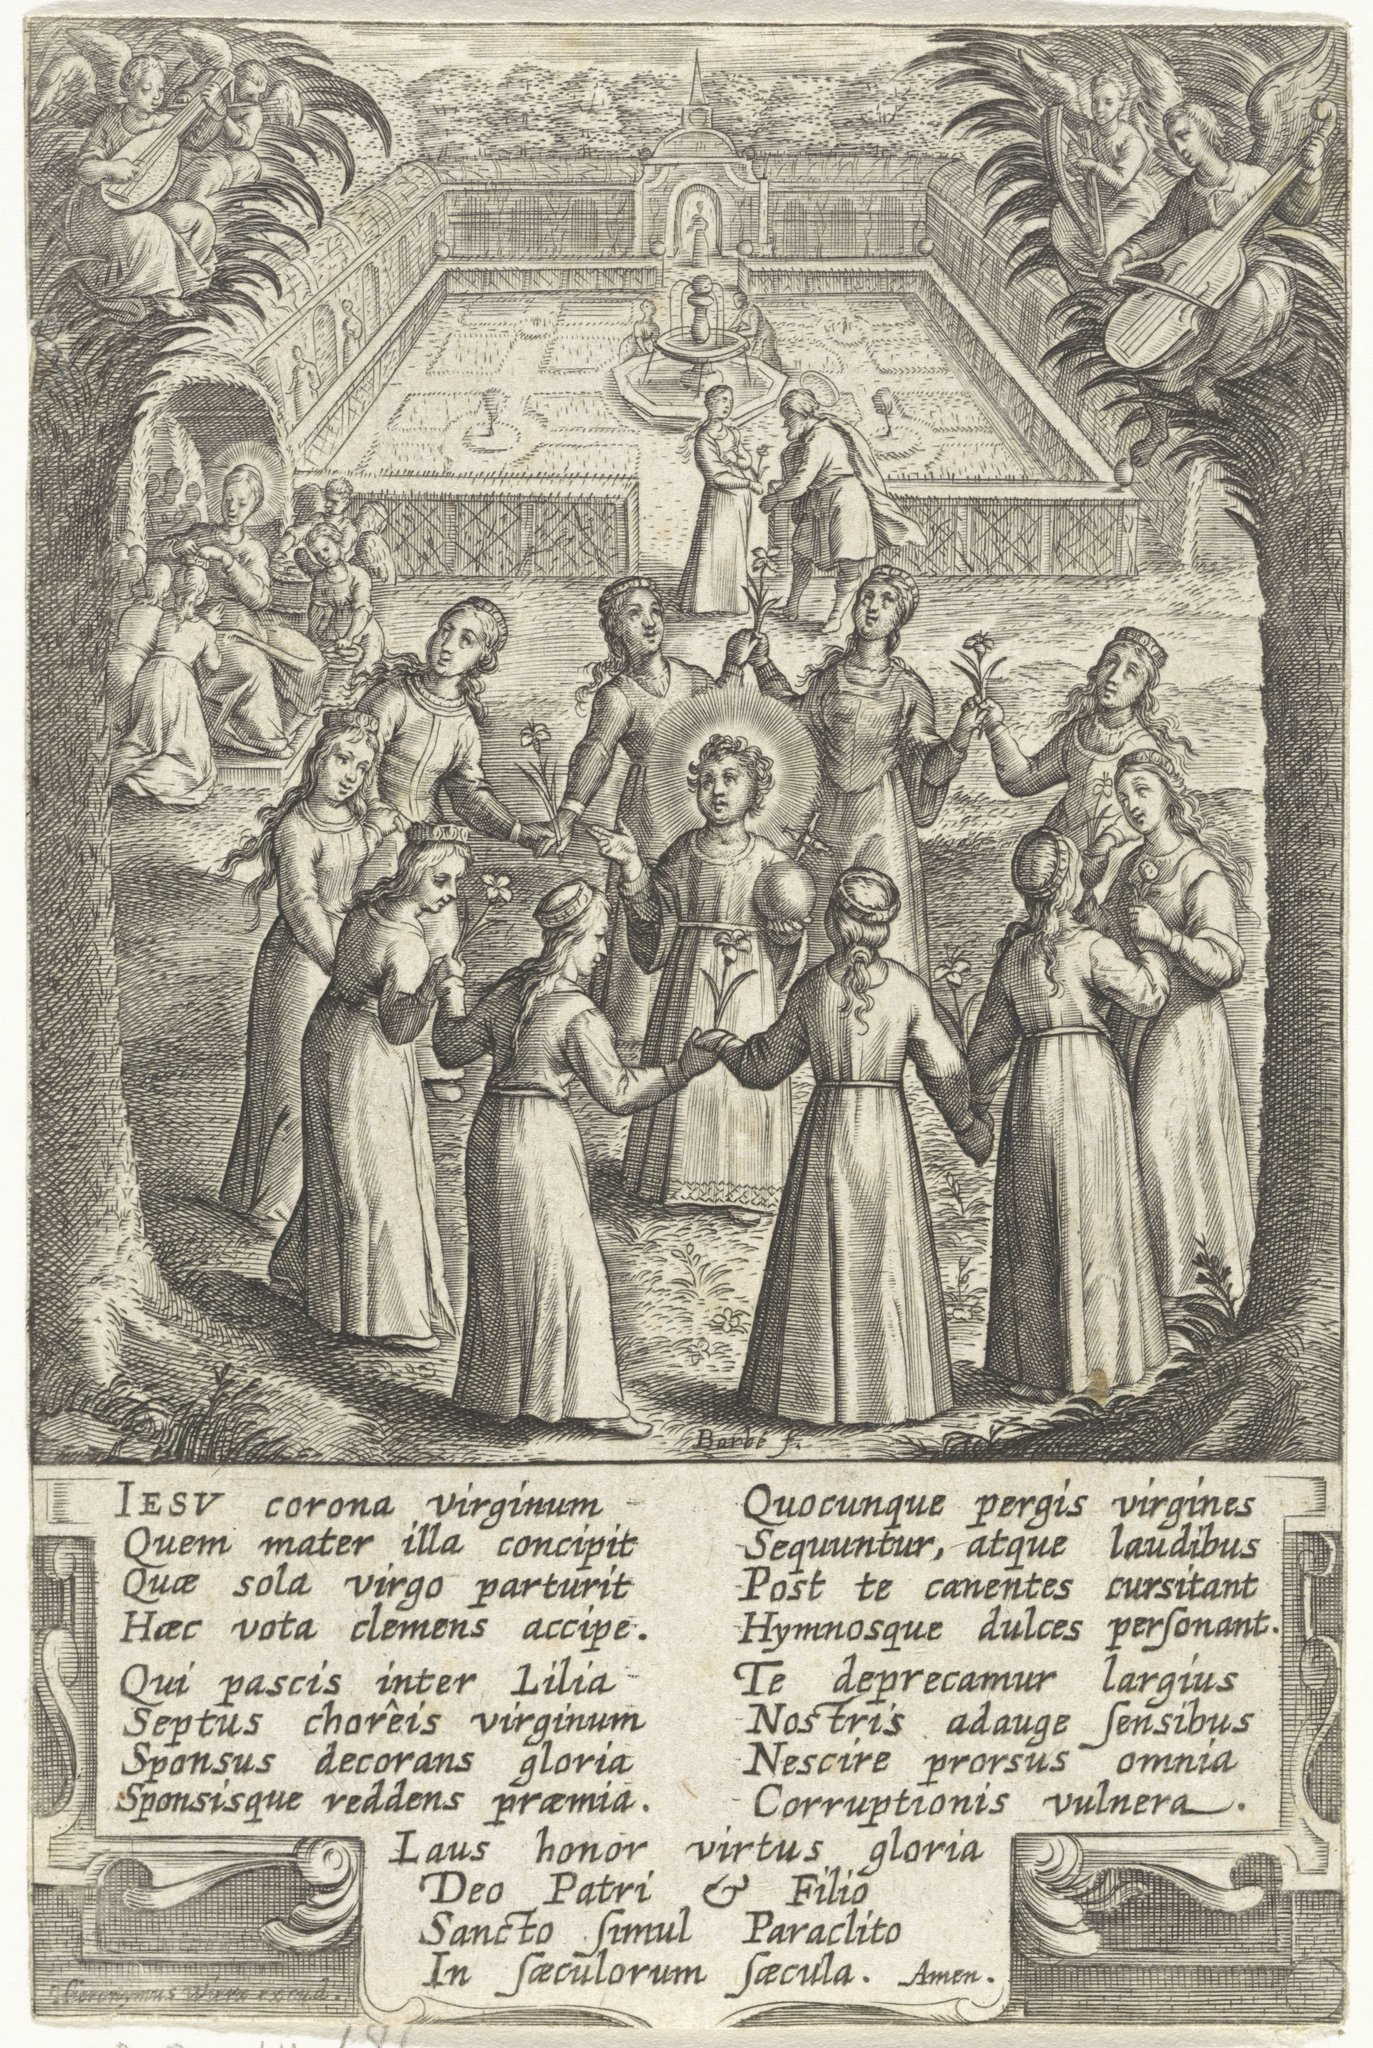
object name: print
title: Christuskind omringd door maagden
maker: hieronymus wierix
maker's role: draughtsman, print maker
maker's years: 1553-1619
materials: paper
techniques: engraving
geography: antwerp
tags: christ-child together with others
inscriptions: collector's mark: Lugt 2228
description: Tien maagden vormen een kring rond het Christuskind. Maria zit aan de rand van een tuin, te midden van engelen, op de achtergrond. In de bomen musicerende engelen. In de marge een gebed, in drie kolommen, in het Latijn.